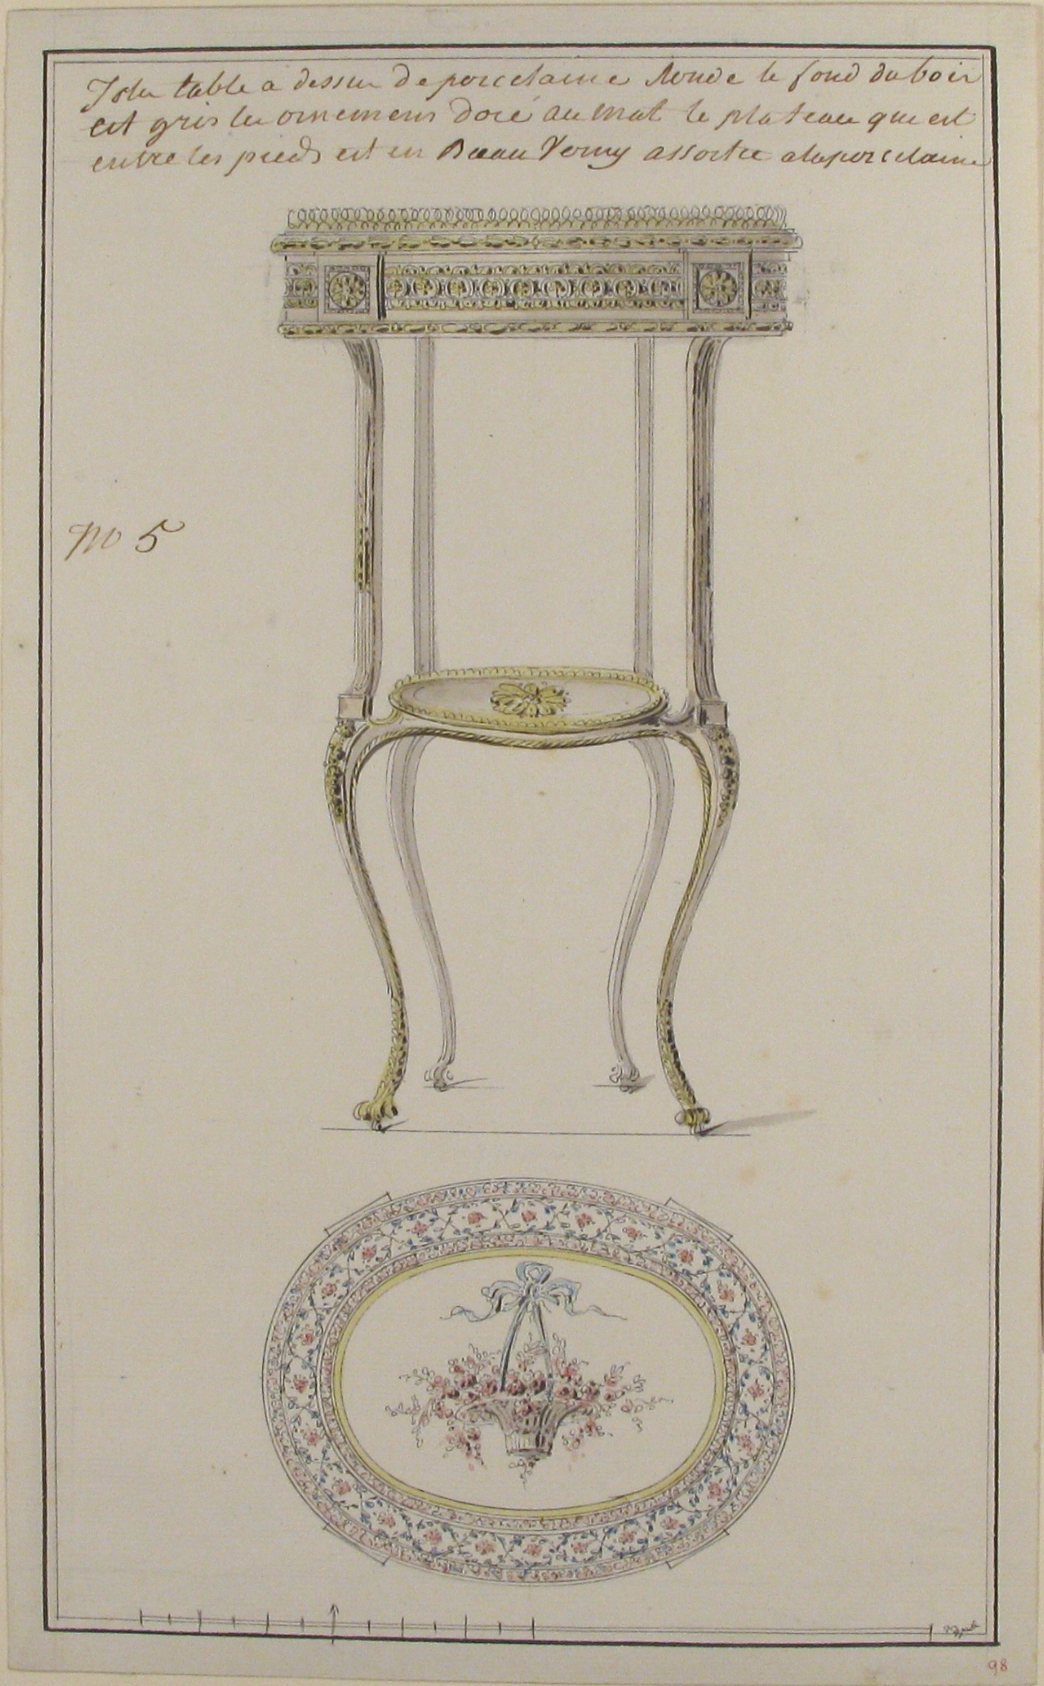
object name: drawing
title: Design for an Occasional Table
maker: anonymous, french, 18th century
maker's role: artist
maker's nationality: french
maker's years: 1700-1800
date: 1770-1785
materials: ink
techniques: brush, pen, wash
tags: tables